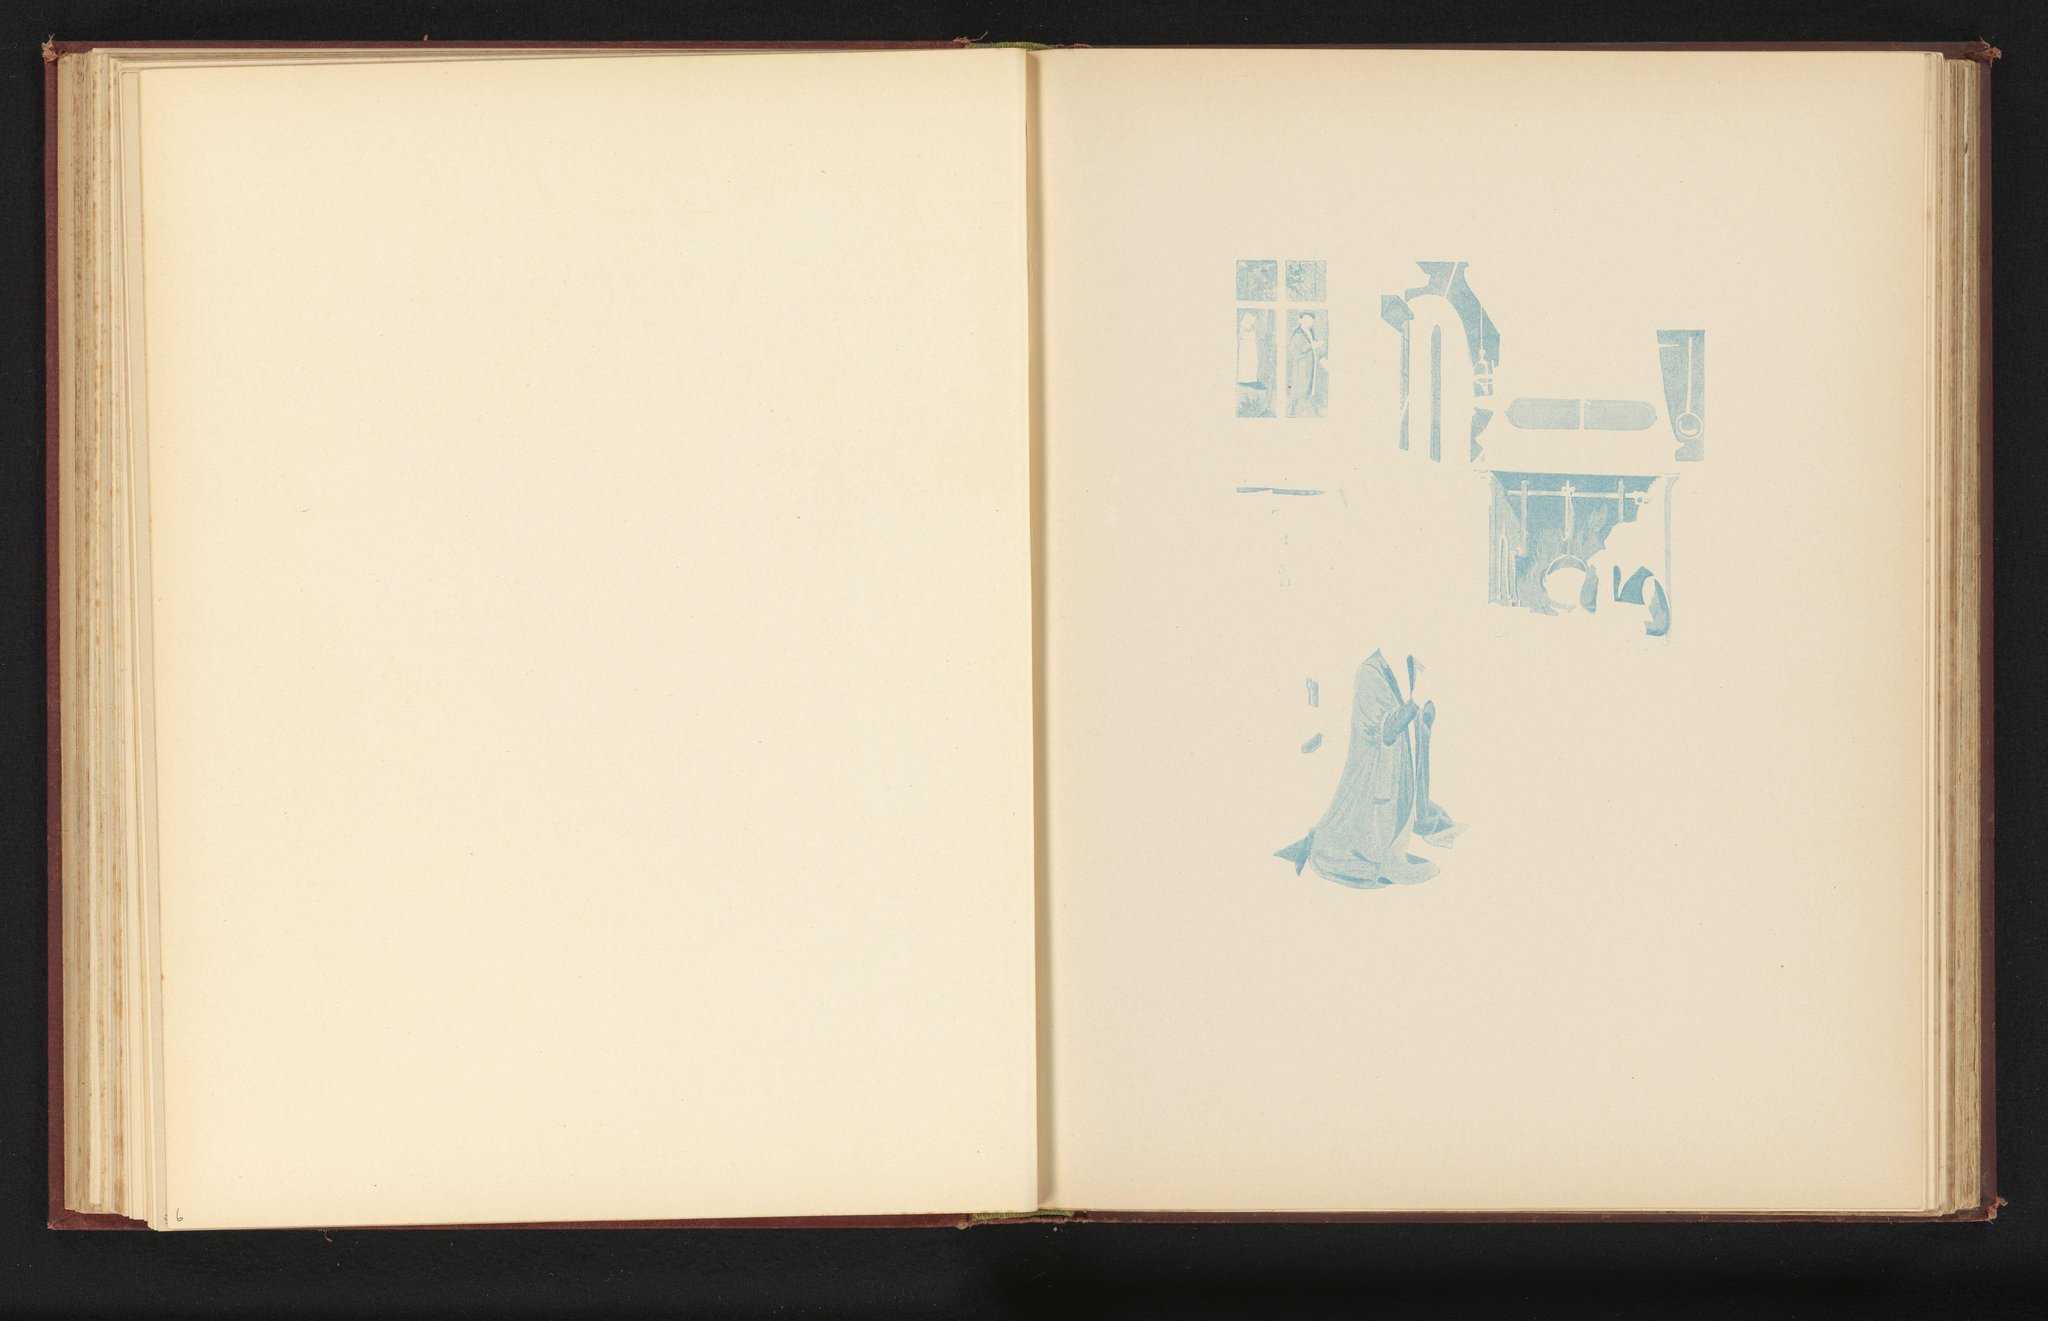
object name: print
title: Reproductie van het schilderij Het mirakel van de gebroken zeef, toonblok in blauw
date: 1889-1894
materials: paper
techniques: chromolithography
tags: kitchen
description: Prent op negende ongenummerde pagina na pagina 104.